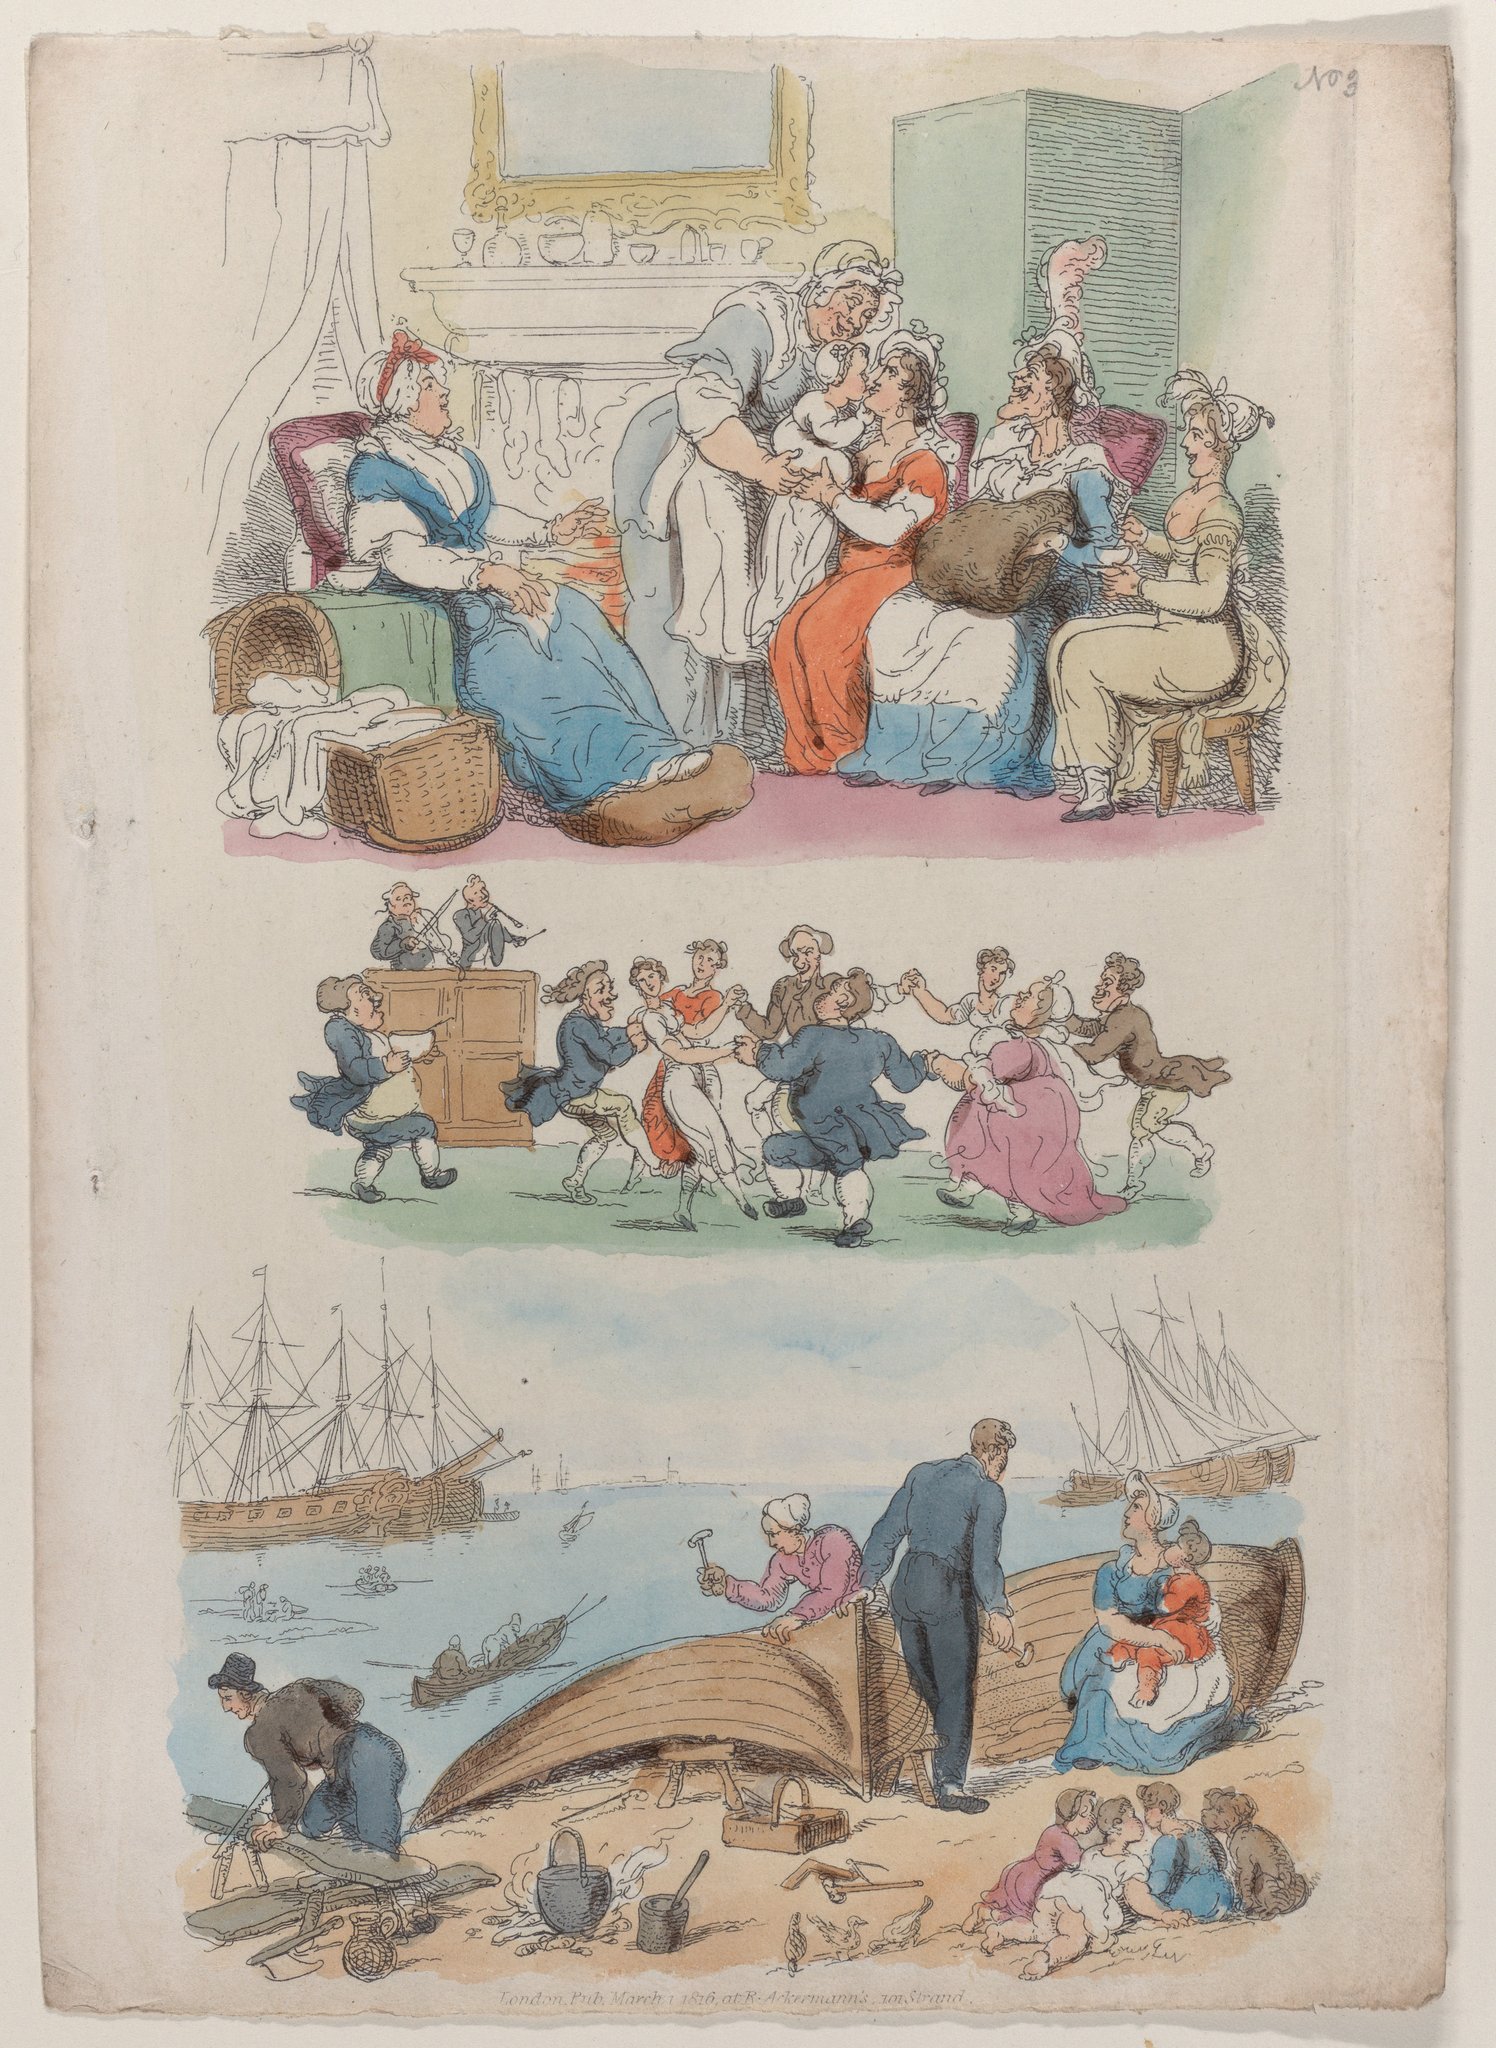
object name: print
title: Plate 4: A Lying-in Visit, A Round Dance, from "World in Miniature"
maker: thomas rowlandson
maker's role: artist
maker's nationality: british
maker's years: 1757-1827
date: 1816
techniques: etching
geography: london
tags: infants,men,women,dancing,boats